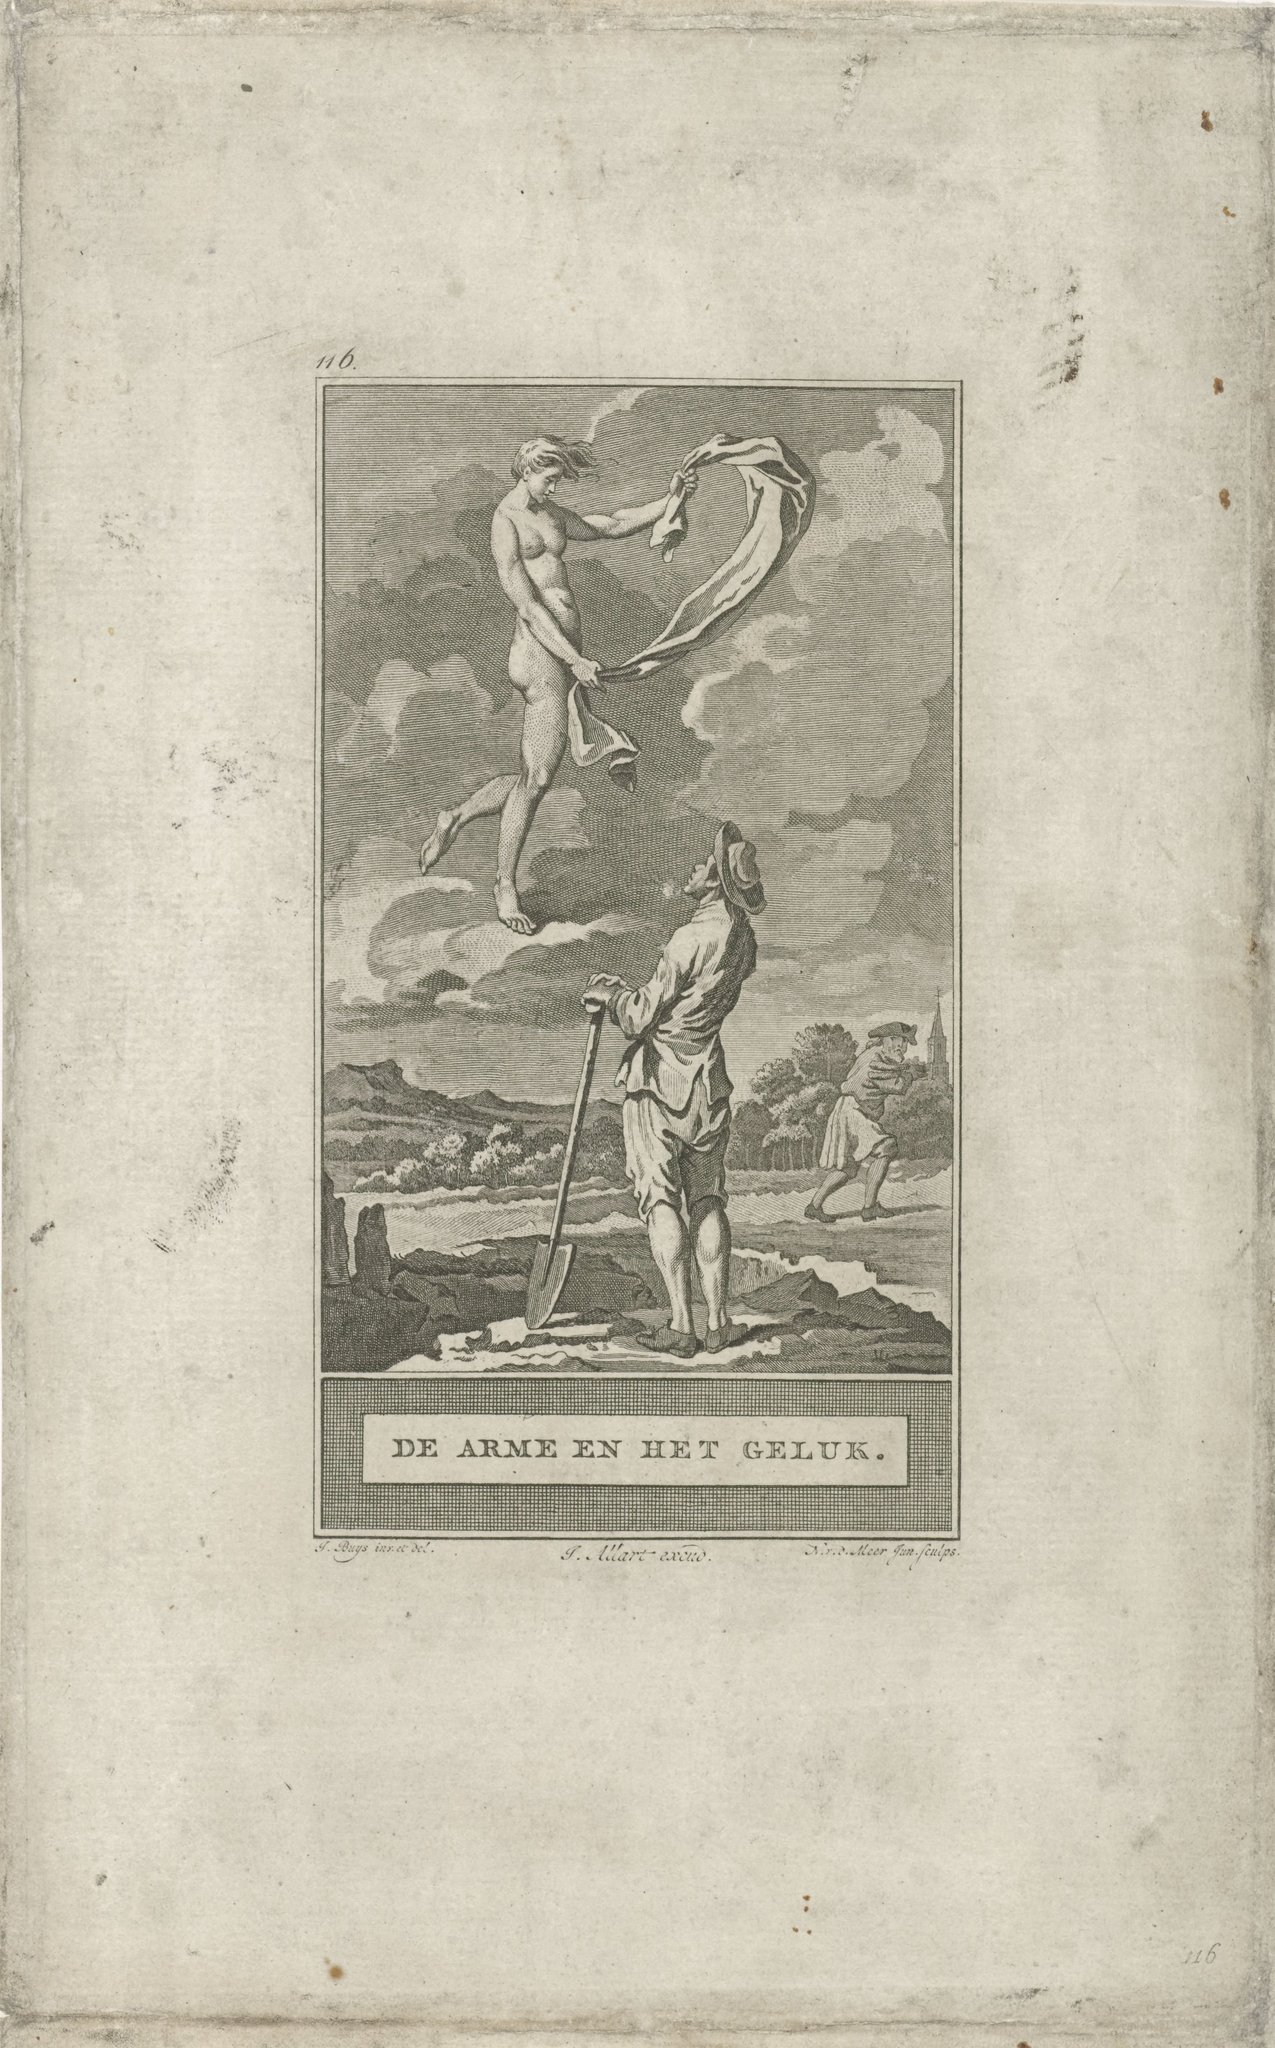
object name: print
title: Fortuin en de arme man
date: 1778-1785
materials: paper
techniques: etching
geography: amsterdam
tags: luck, fortune, lot; 'fato', 'fortuna', 'fortuna aurea', 'fortuna buona', 'fortuna pacifica overo clemente', 'sorte' (ripa), the poor, digging for or finding of treasure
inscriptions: collector's mark: Lugt 2228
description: Prent bij: Gellert, Christian Fürchtegott. Fabelen en vertelsels. 3 dln. Amsterdam: Pieter Meyer, 1772-1774. De prenten bij deze publicatie werden later uitgegeven. De exemplaren uitgegeven door de weduwe Jacobus Loveringh & Johannes Allart tussen 1777 en 1778, de exemplaren uitgegeven door alleen Johannes Allart tussen 1778 en 1785.